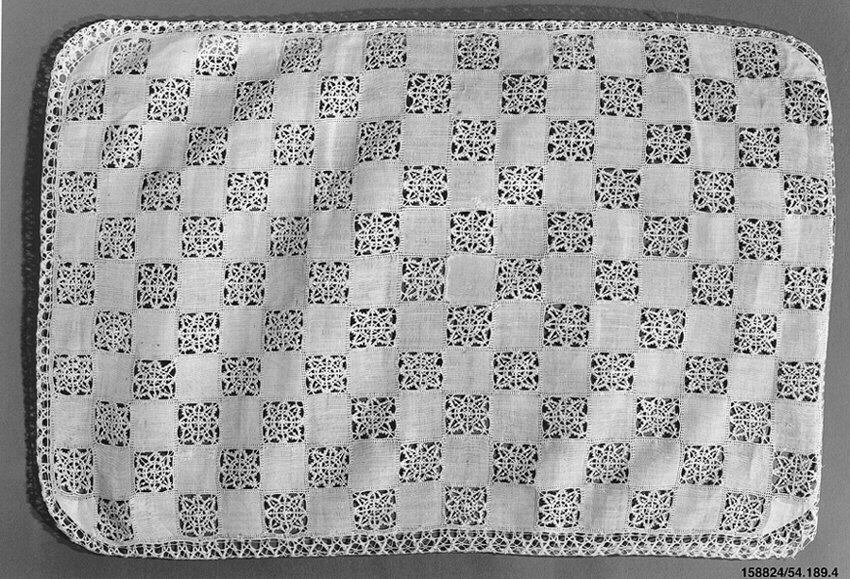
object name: pillowcase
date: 1601-1700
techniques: lace